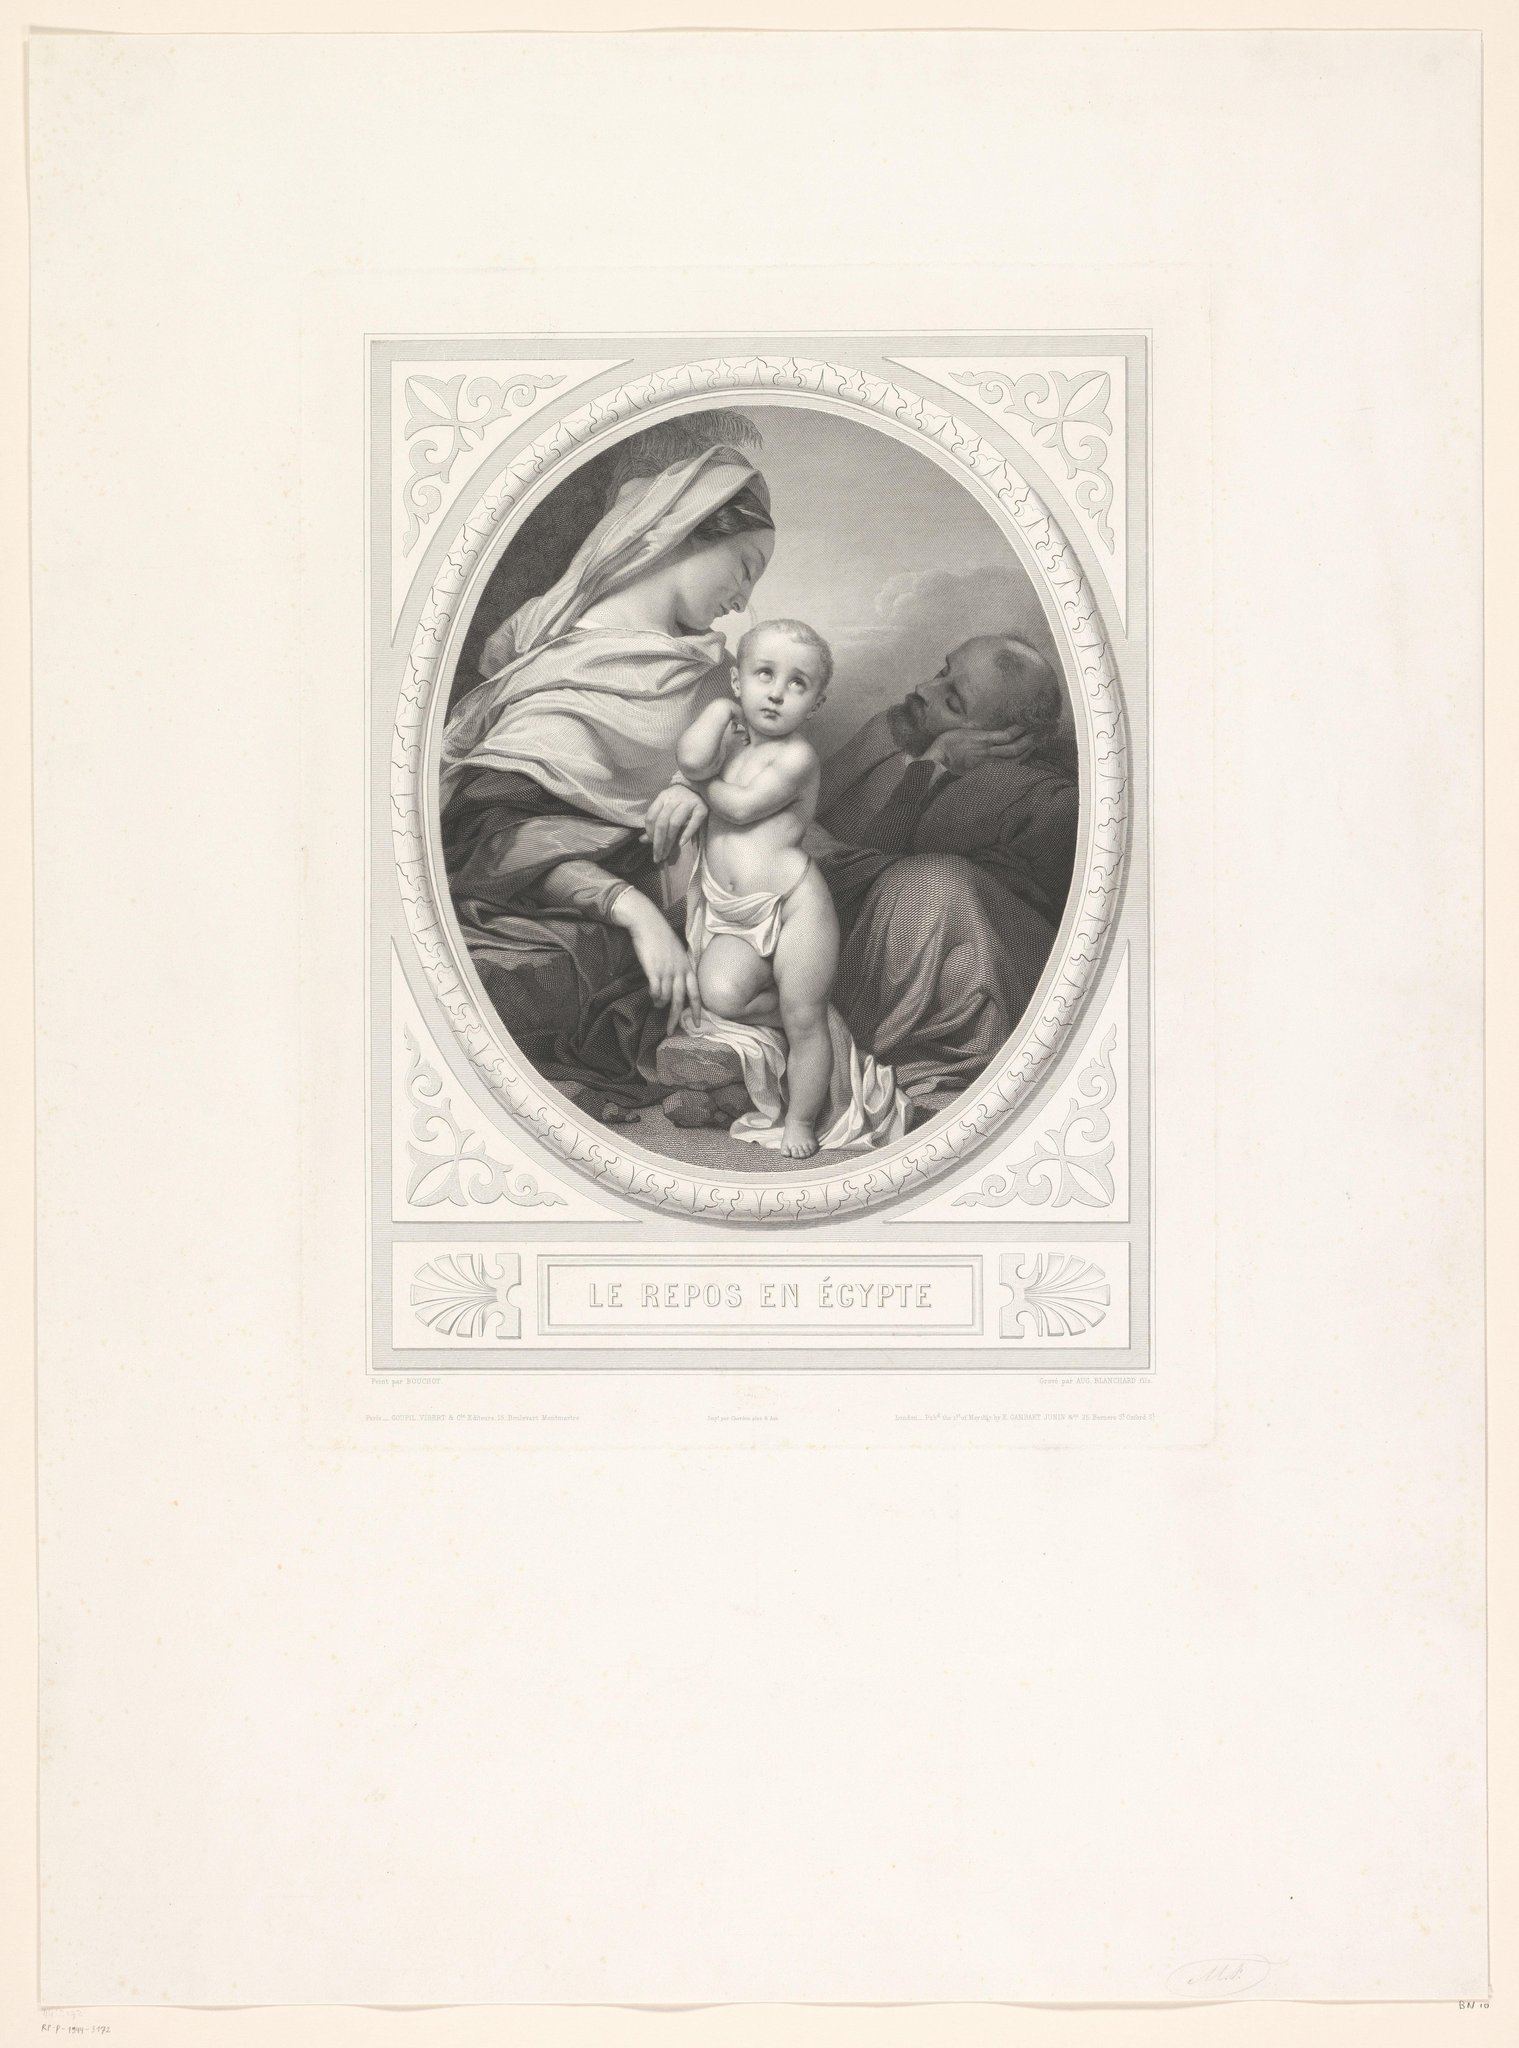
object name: print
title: Rust op de vlucht naar Egypte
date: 1847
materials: paper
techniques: engraving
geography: london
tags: rest on the flight into egypt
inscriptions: check stamp: Lugt 5003, collector's mark: Lugt 2228